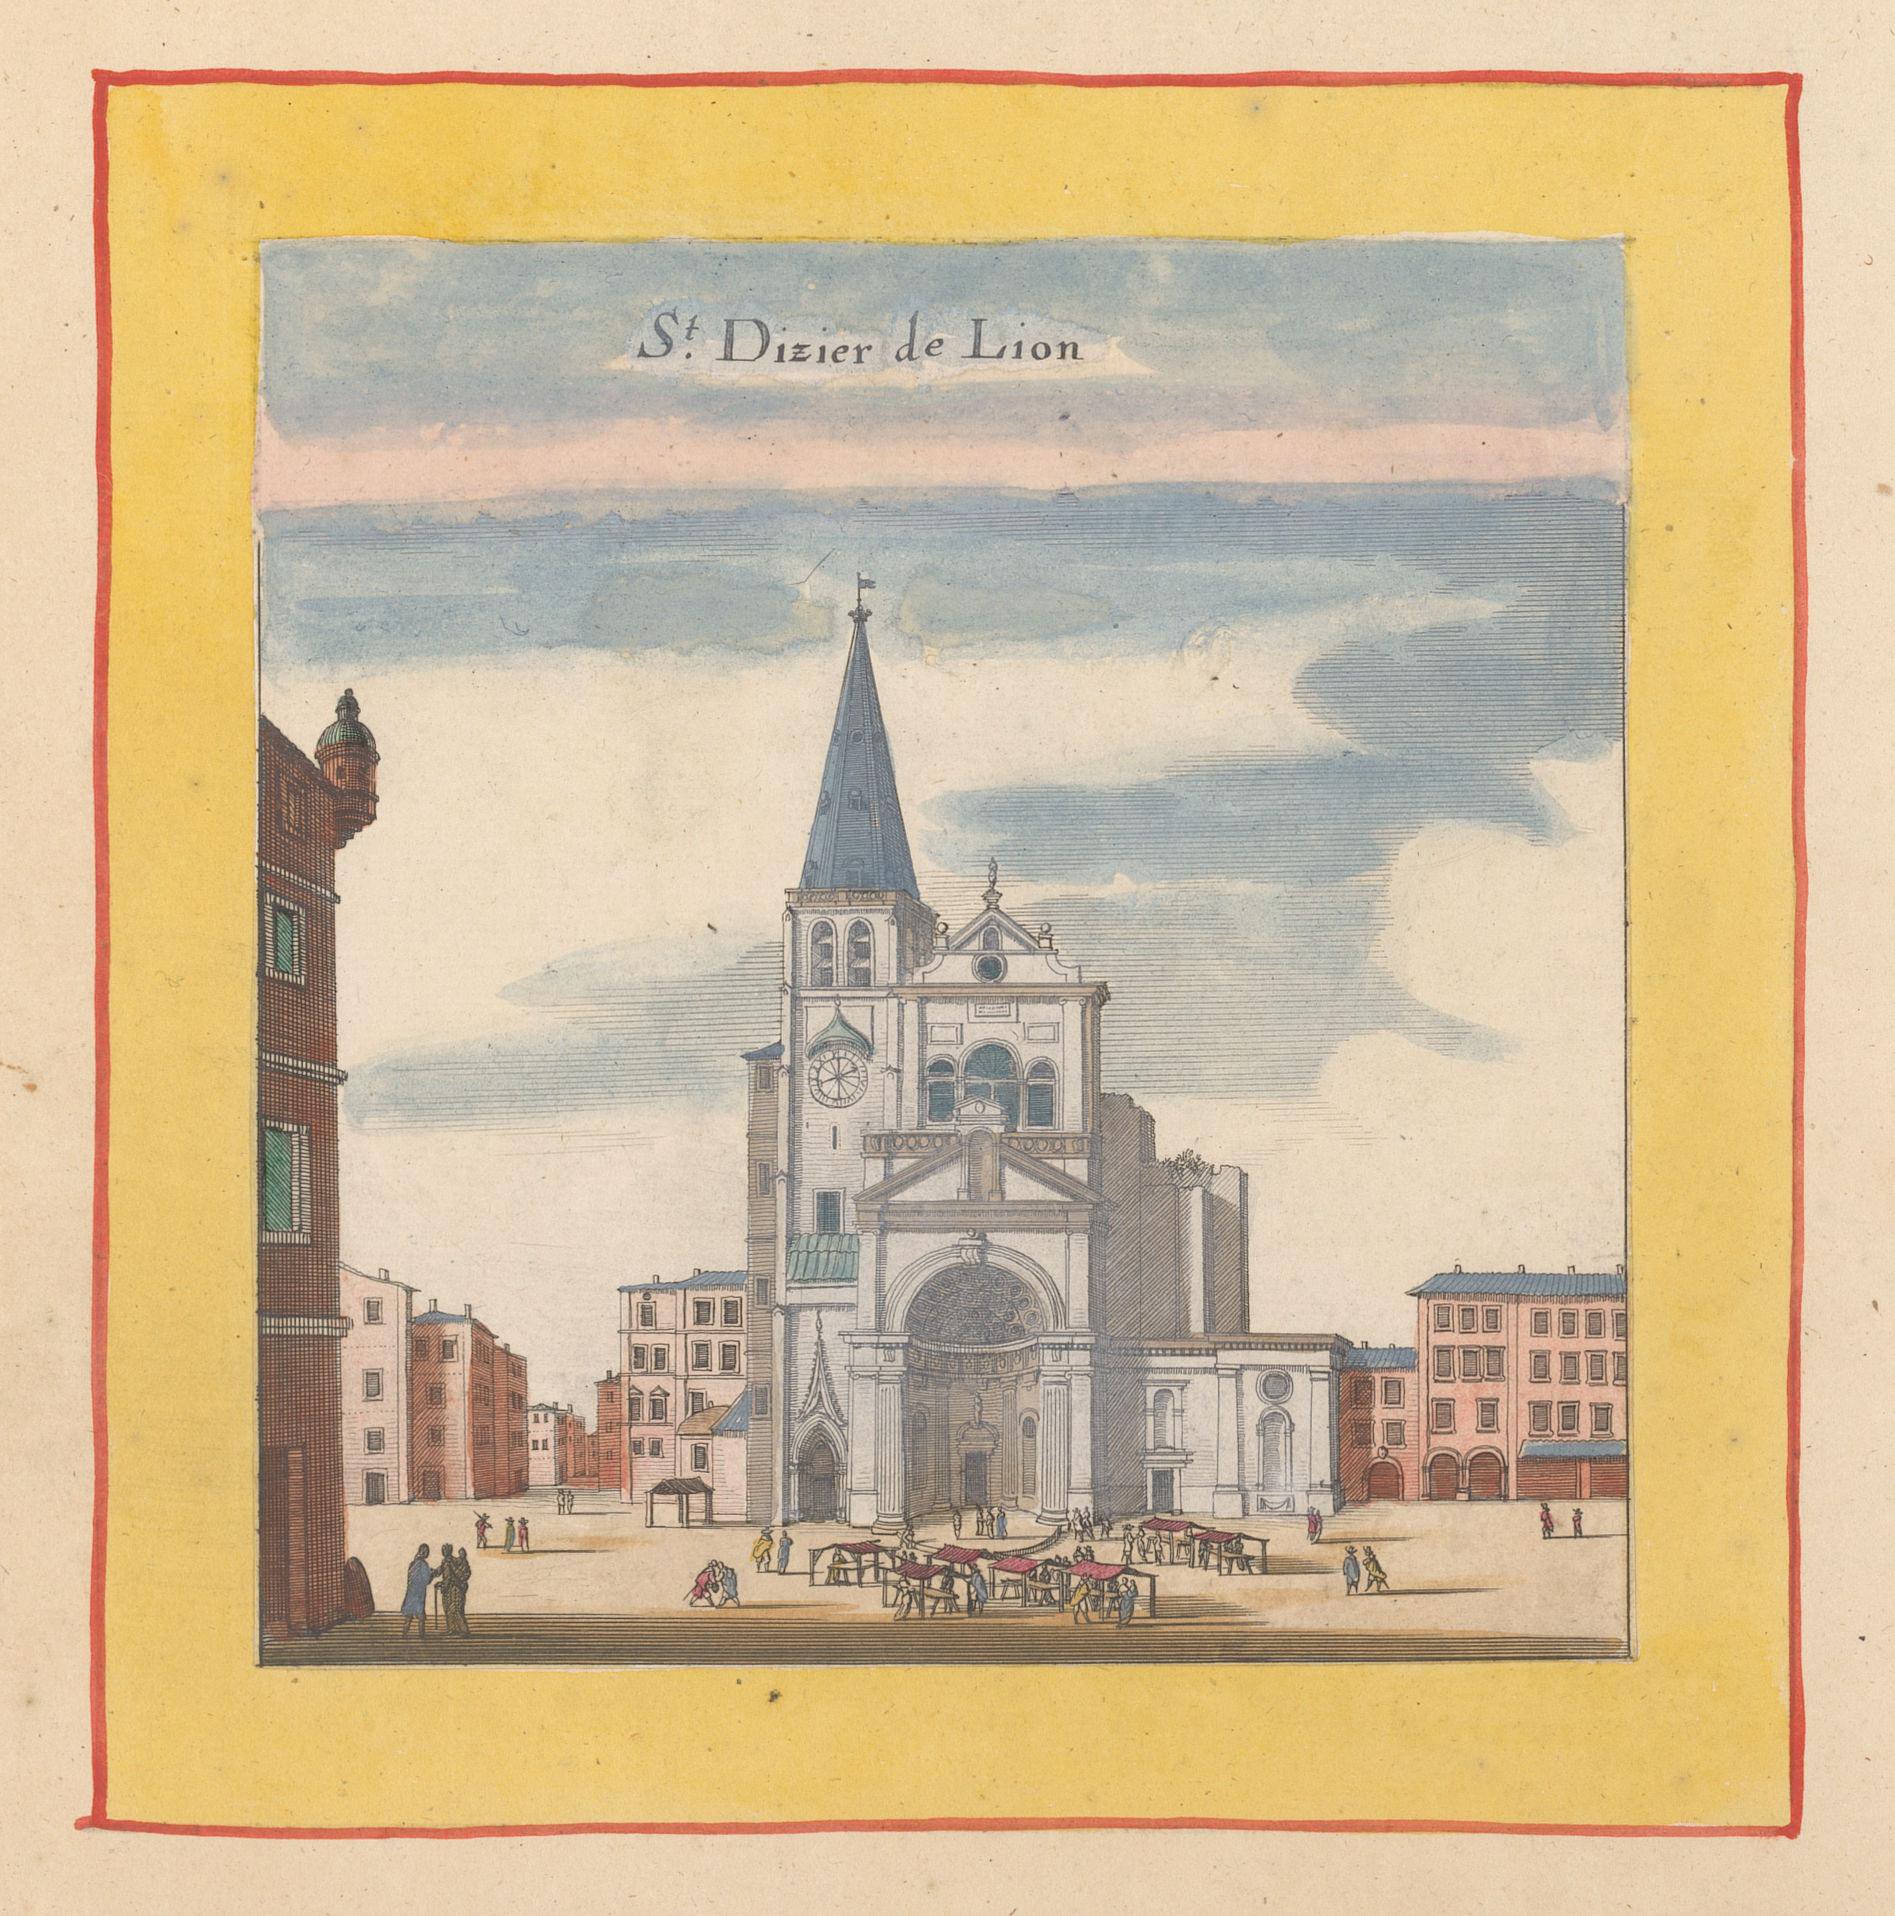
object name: album leaf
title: Gezicht op de Église Saint-Nizier in Lyon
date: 1657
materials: paper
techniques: engraving, etching, hand coloring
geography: frankfurt am main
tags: city-view in general; 'veduta', church (exterior), lyon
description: Prent uit: Zeiller, Martin. Topographia Galliae. 13 dln. Frankfurt: Caspar Merian, 1657, dl. 5, na p. 14. De titel is uit de originele prent gesneden. Boven de gravure is een deel lucht en wolken (bij)geschilderd, waarin de titel gelijmd is. Origineel op één blad gedrukt met een gezicht op de Église Saint-Bonaventure (RP-P-1957-607-40-1).